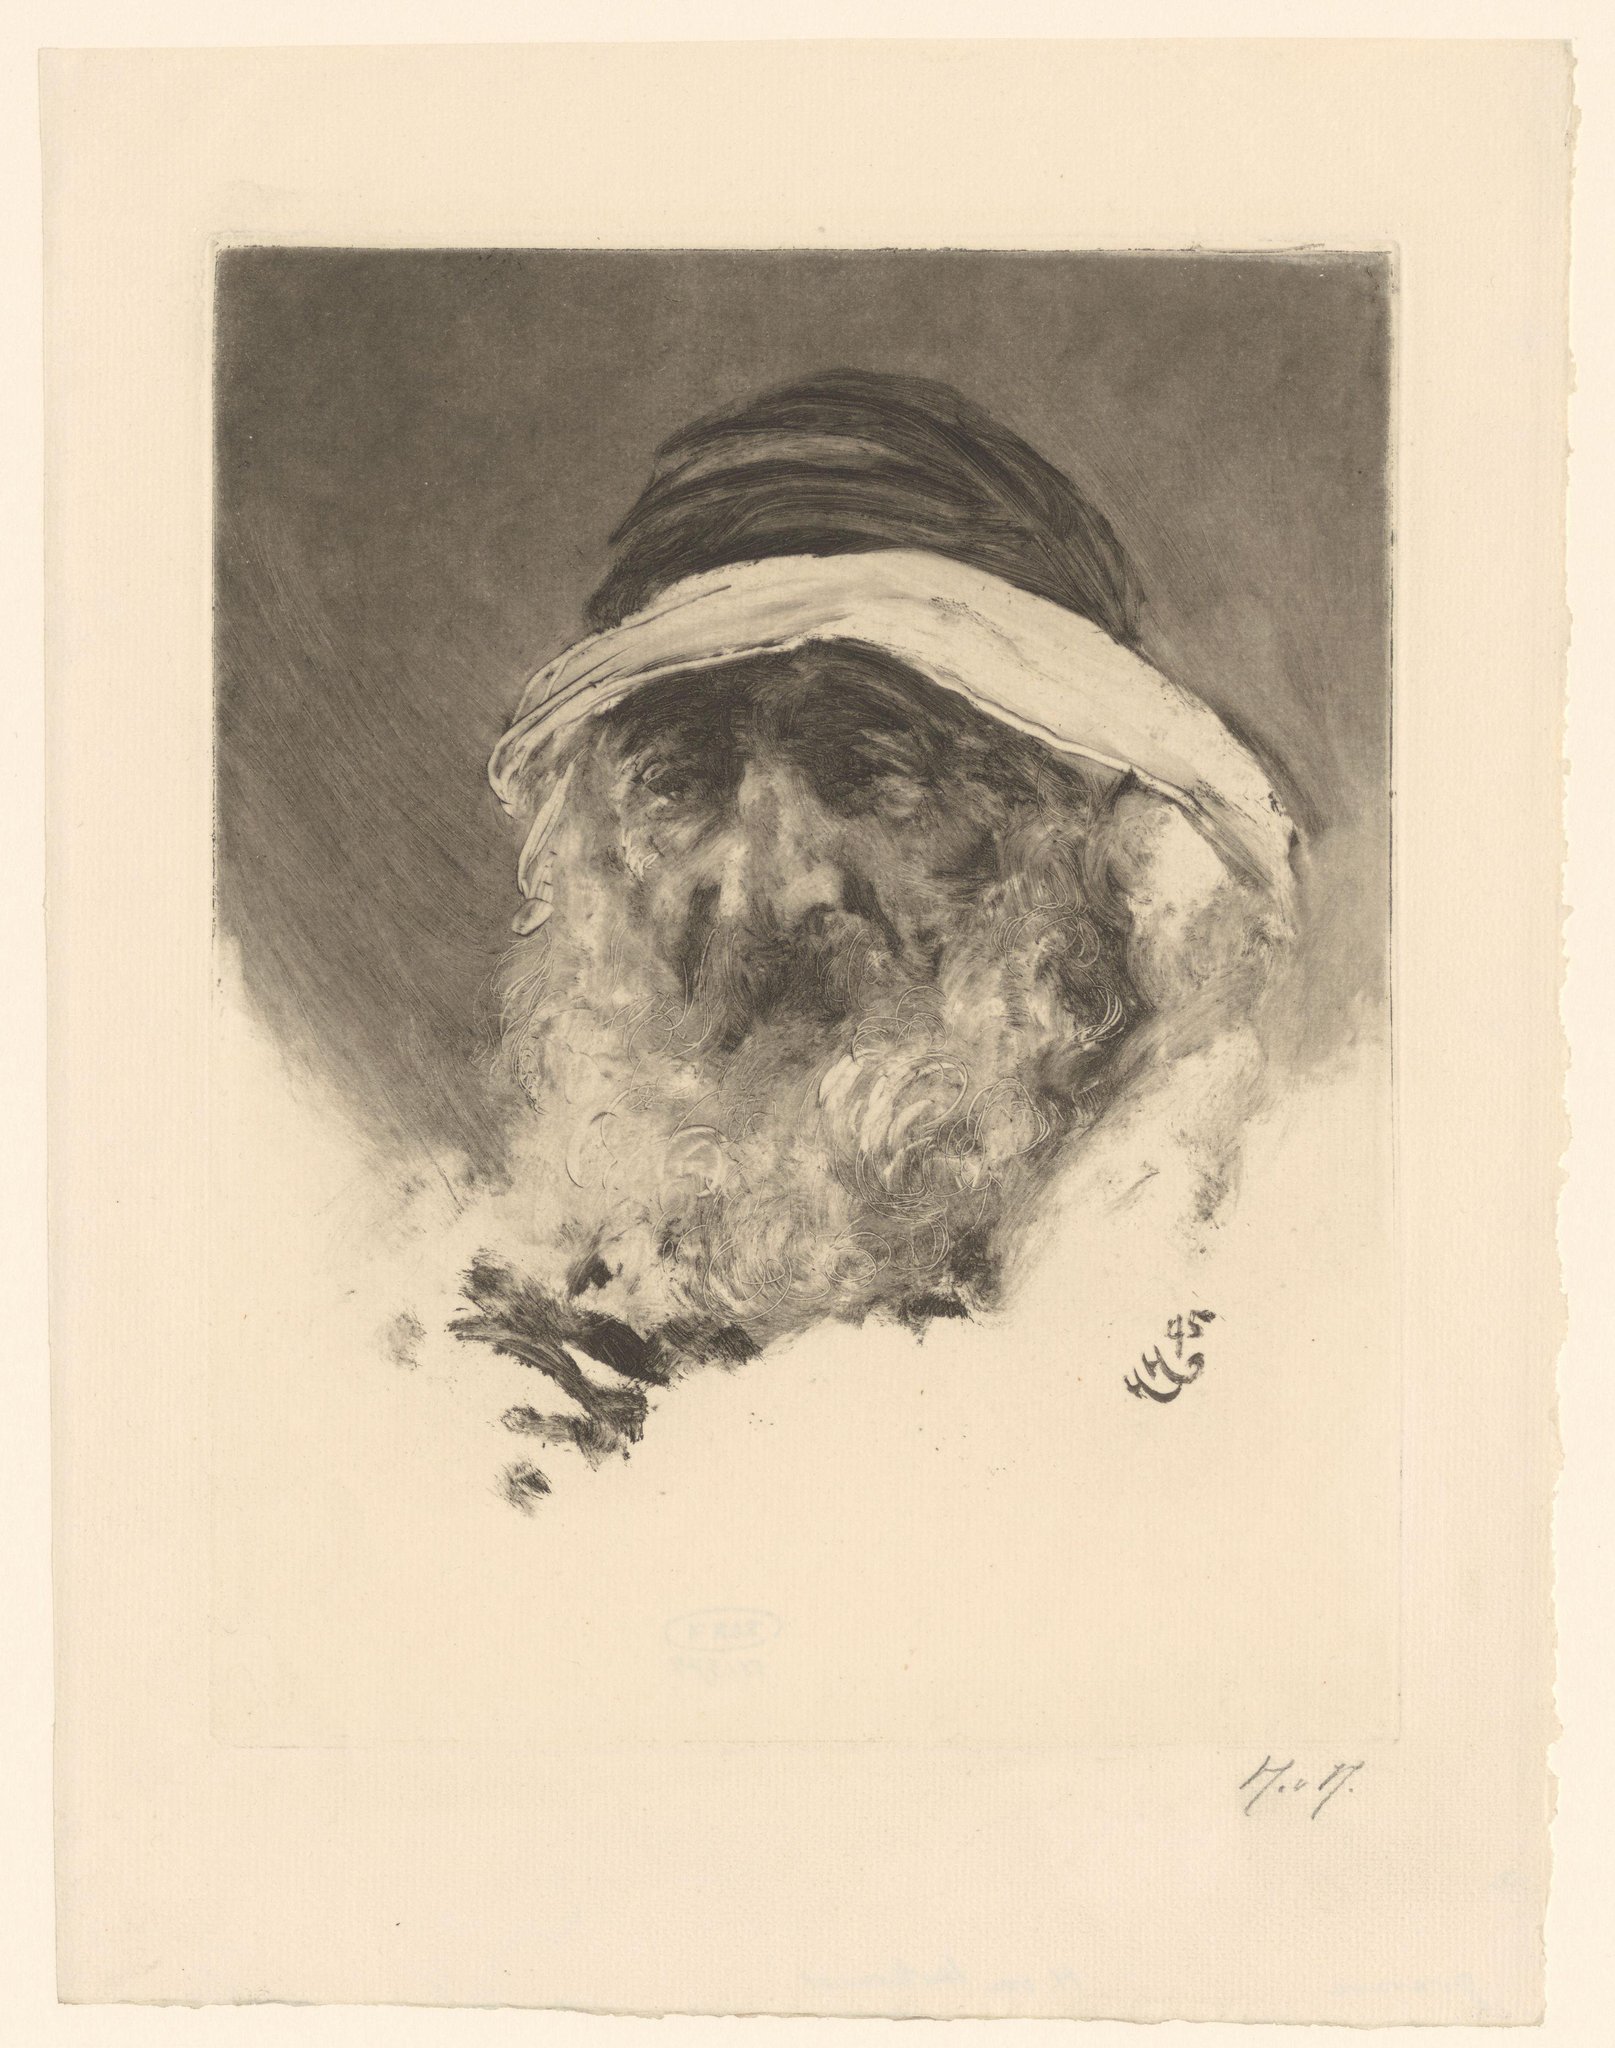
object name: print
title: Portret van een onbekende oude man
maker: hubert von herkomer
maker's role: painter, print maker, sculptor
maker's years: 1849-1914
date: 1895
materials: paper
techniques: photoaquatint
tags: historical persons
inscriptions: collector's mark: Lugt 2228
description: Hubert von Herkomer was de uitvinder van een techniek waarin de monotype techniek en heliogravure gecombineerd werden, deze methode is vervolgens ook naar hem vernoemd: het 'Herkotype', 'spongotype' en 'herkomertype'.